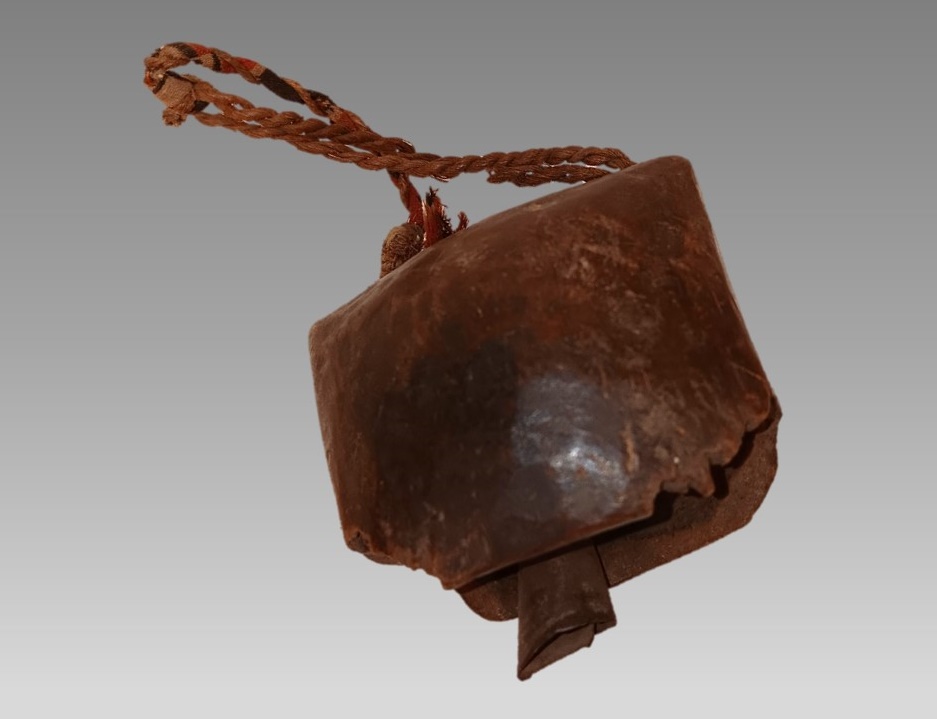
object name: ngonge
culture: congolese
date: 1867-1900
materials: wood